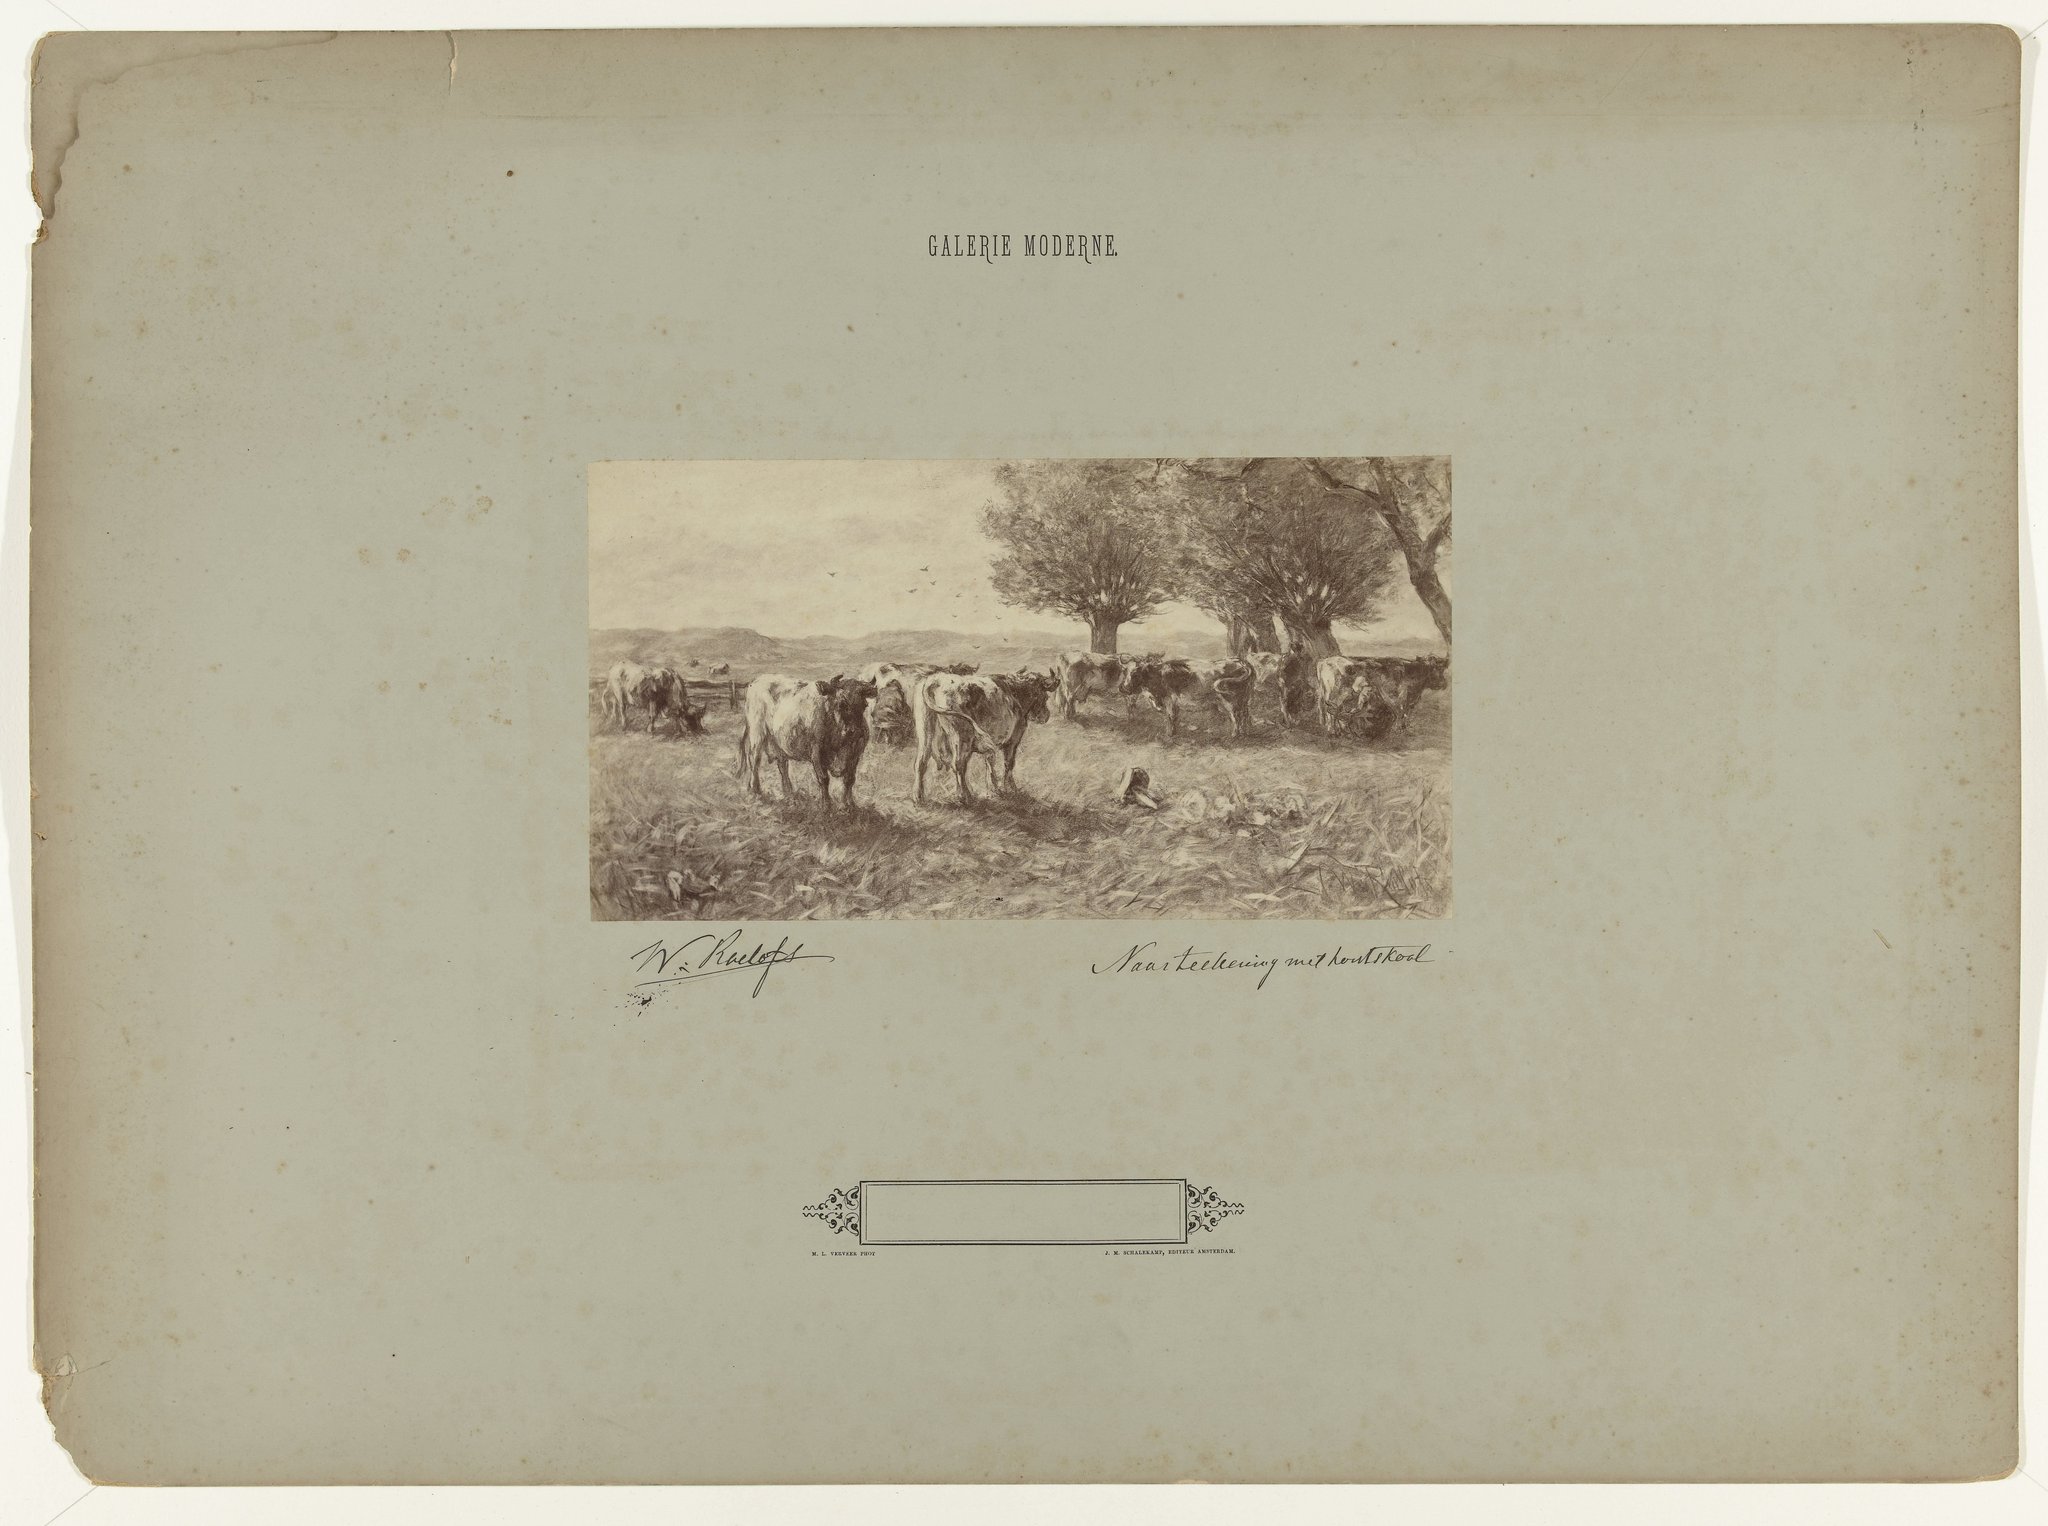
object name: photograph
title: Fotoreproductie van tekening Landschap met koeien bij bomen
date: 1875-1890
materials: cardboard, photographic support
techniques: albumen print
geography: amsterdam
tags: picture, painting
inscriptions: inscription: ‘Naar tekening met houtskool’